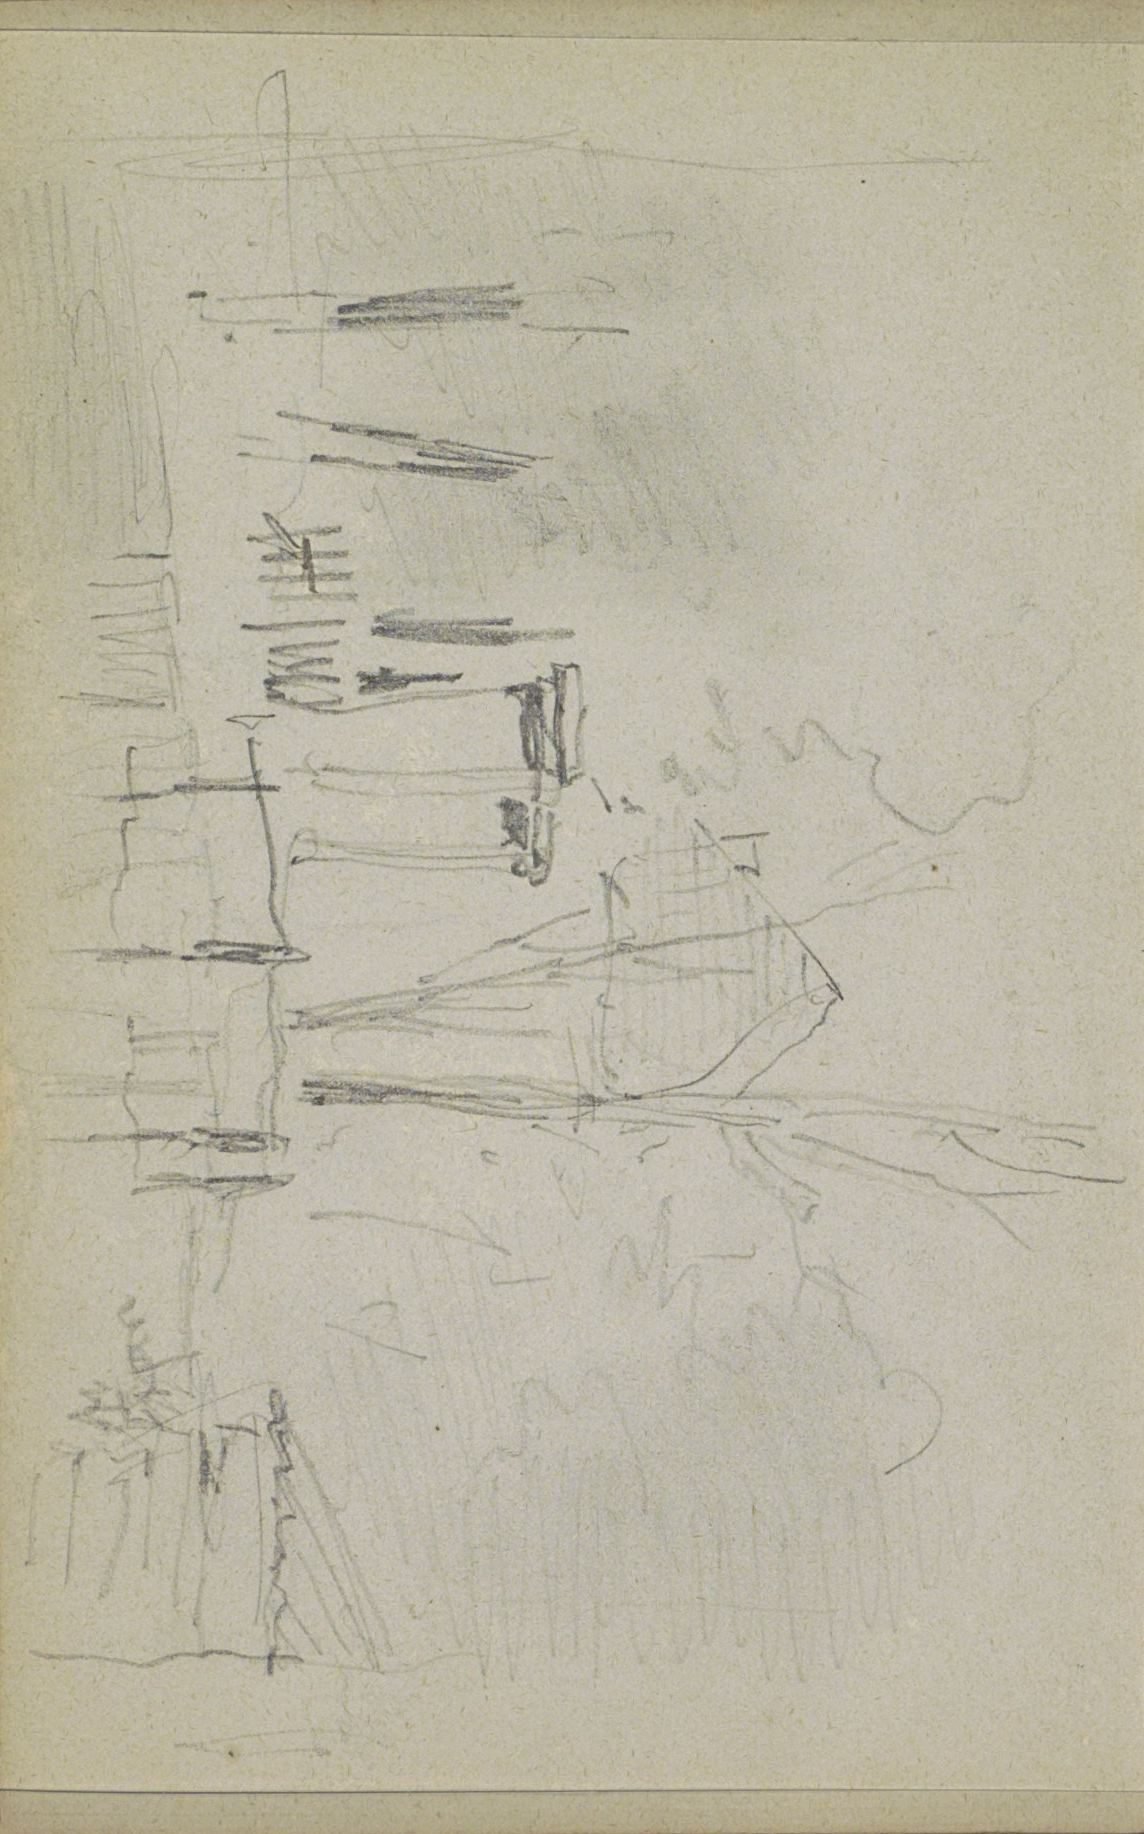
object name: sketchbook leaf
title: Gezicht op gebouwen aan het water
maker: adrianus eversen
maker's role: draughtsman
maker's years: 1818-1897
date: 1828-1897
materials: paper, pencil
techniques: stumping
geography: netherlands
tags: landscapes with waters, waterscapes, seascapes (in the temperate zone), gate, entrance, civic architecture; edifices; dwellings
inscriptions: kleurnotitie, handgeschreven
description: Gebouwen aan het water. Links mogelijk een toegangspoort. Blad 55 verso uit een schetsboek met 58 bladen.